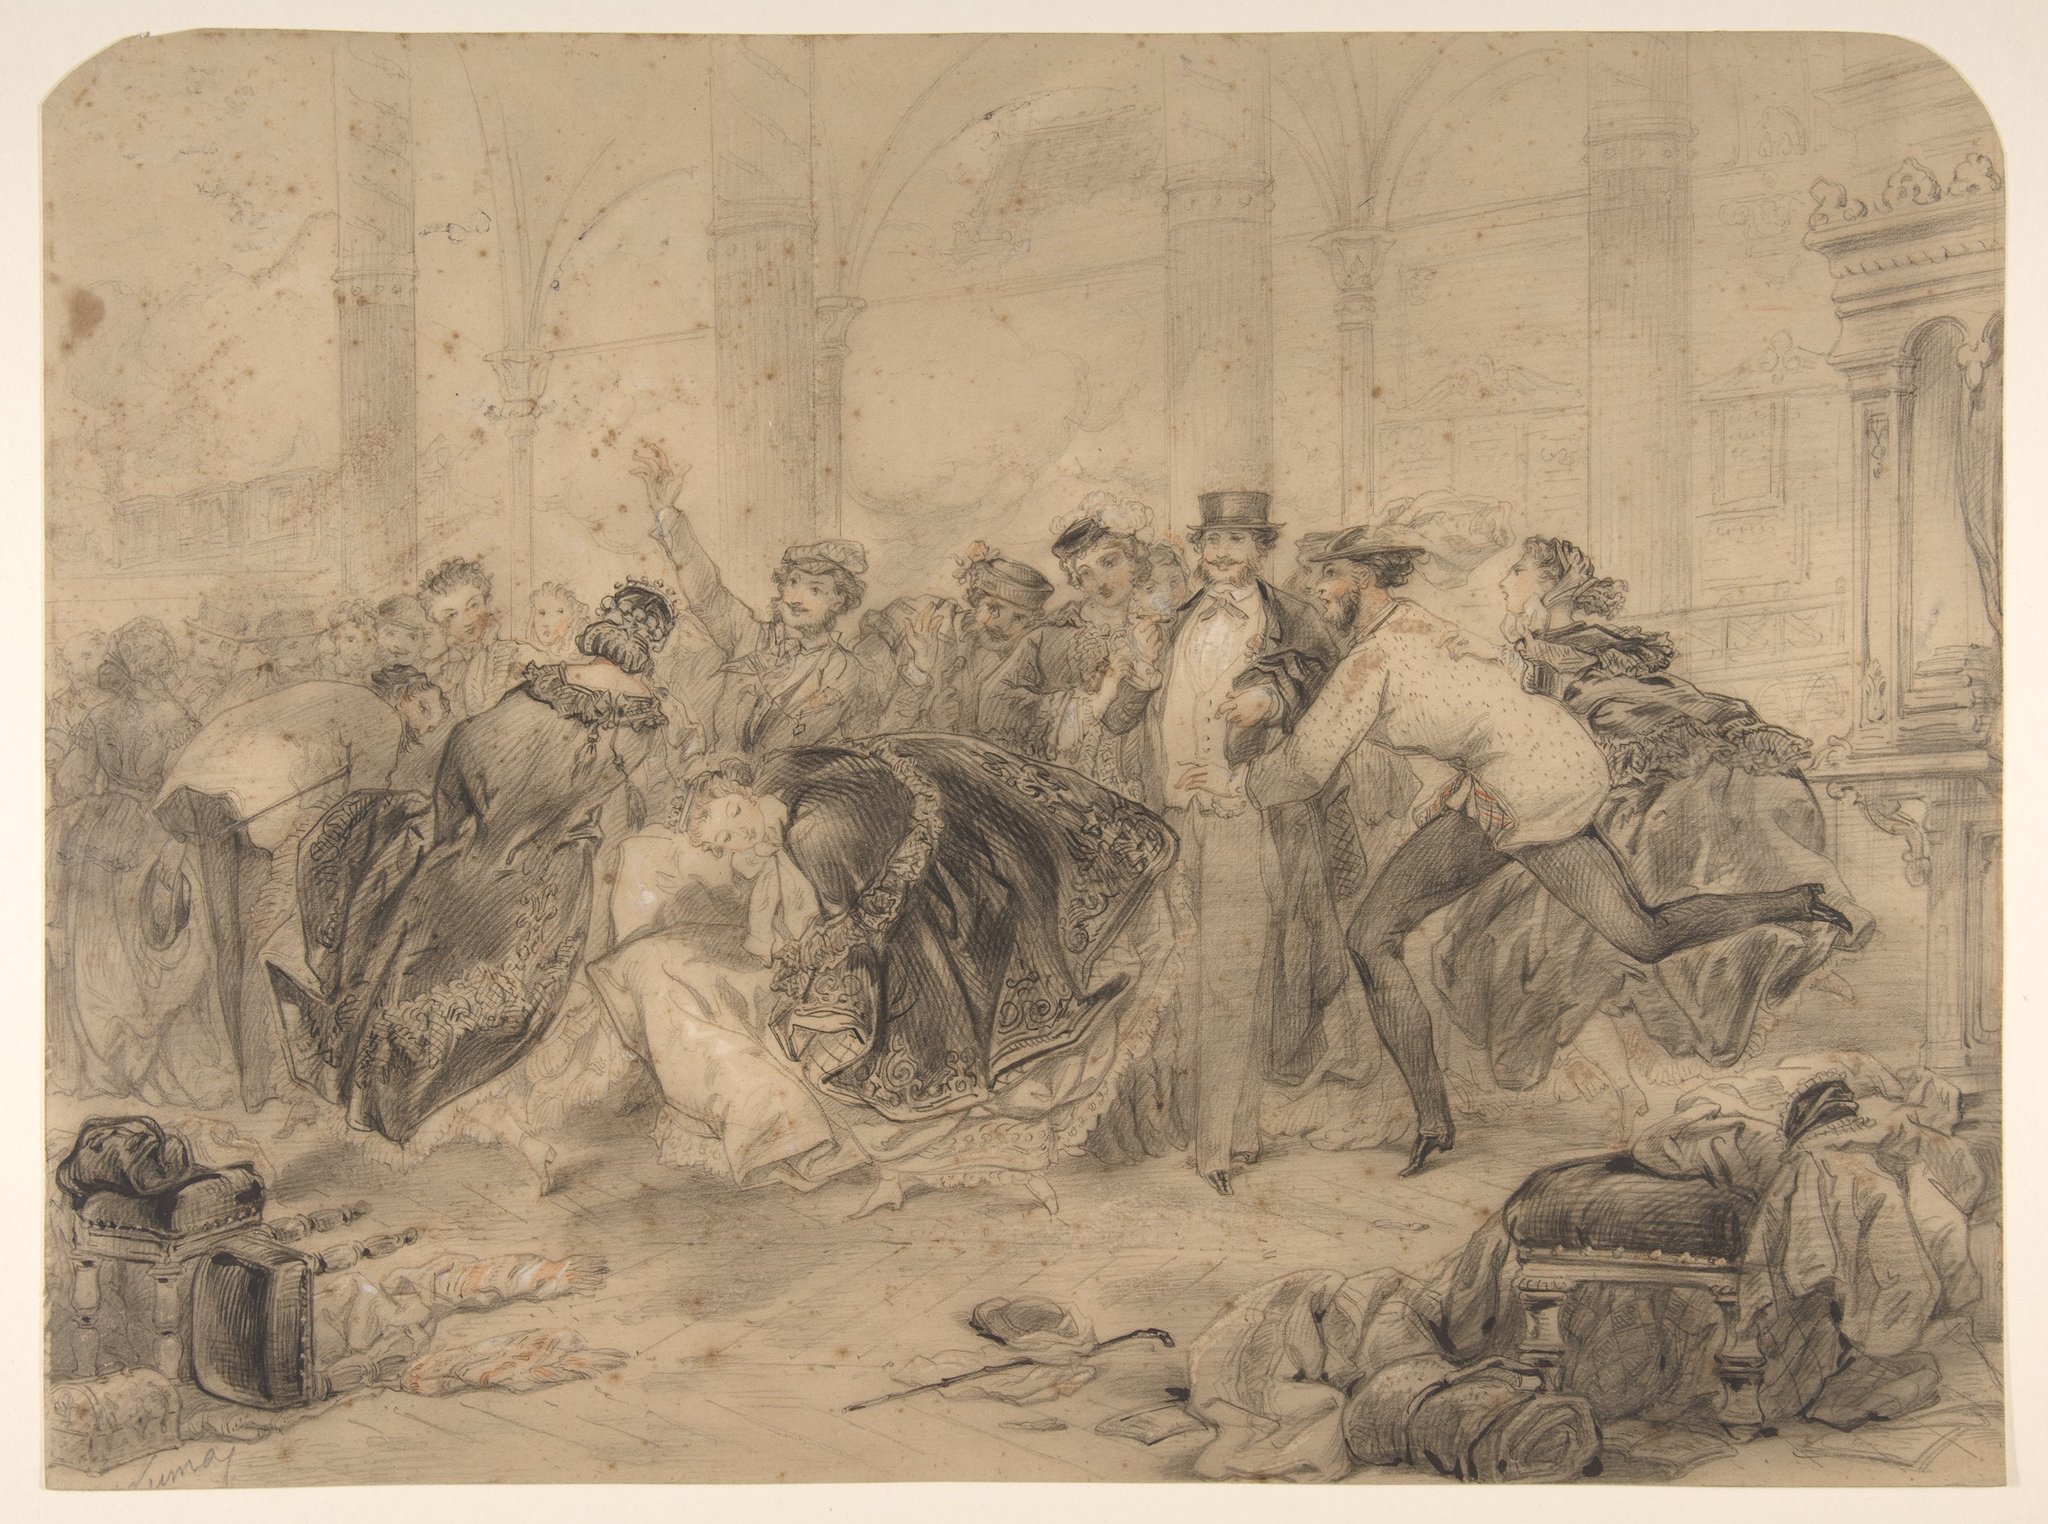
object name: drawing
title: Crowd Leaving a Theater (?)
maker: pierre-numa bassaget, called numa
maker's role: artist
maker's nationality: french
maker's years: 1830-1854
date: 1801-1900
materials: chalk, graphite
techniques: heightening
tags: theatre,men,women,crowd